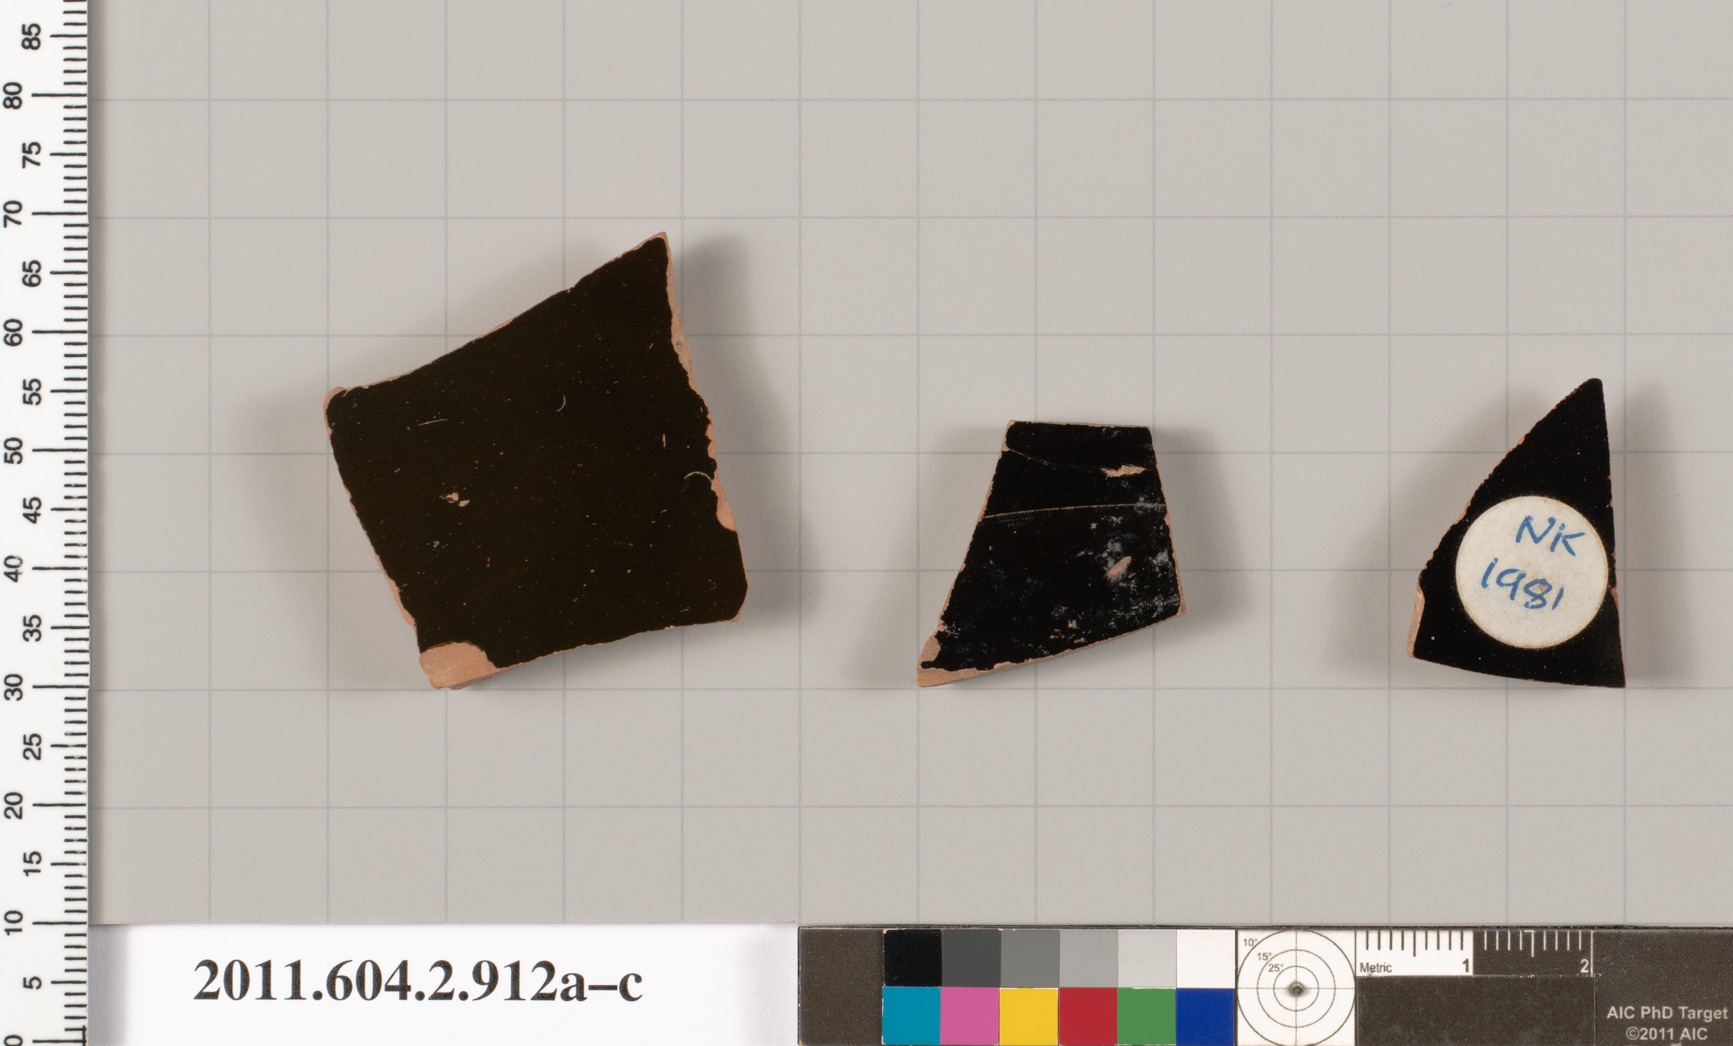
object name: bell krater fragment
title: Terracotta fragments of bell-kraters (bowls for mixing wine and water)?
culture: greek, attic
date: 450-401 BCE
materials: terracotta